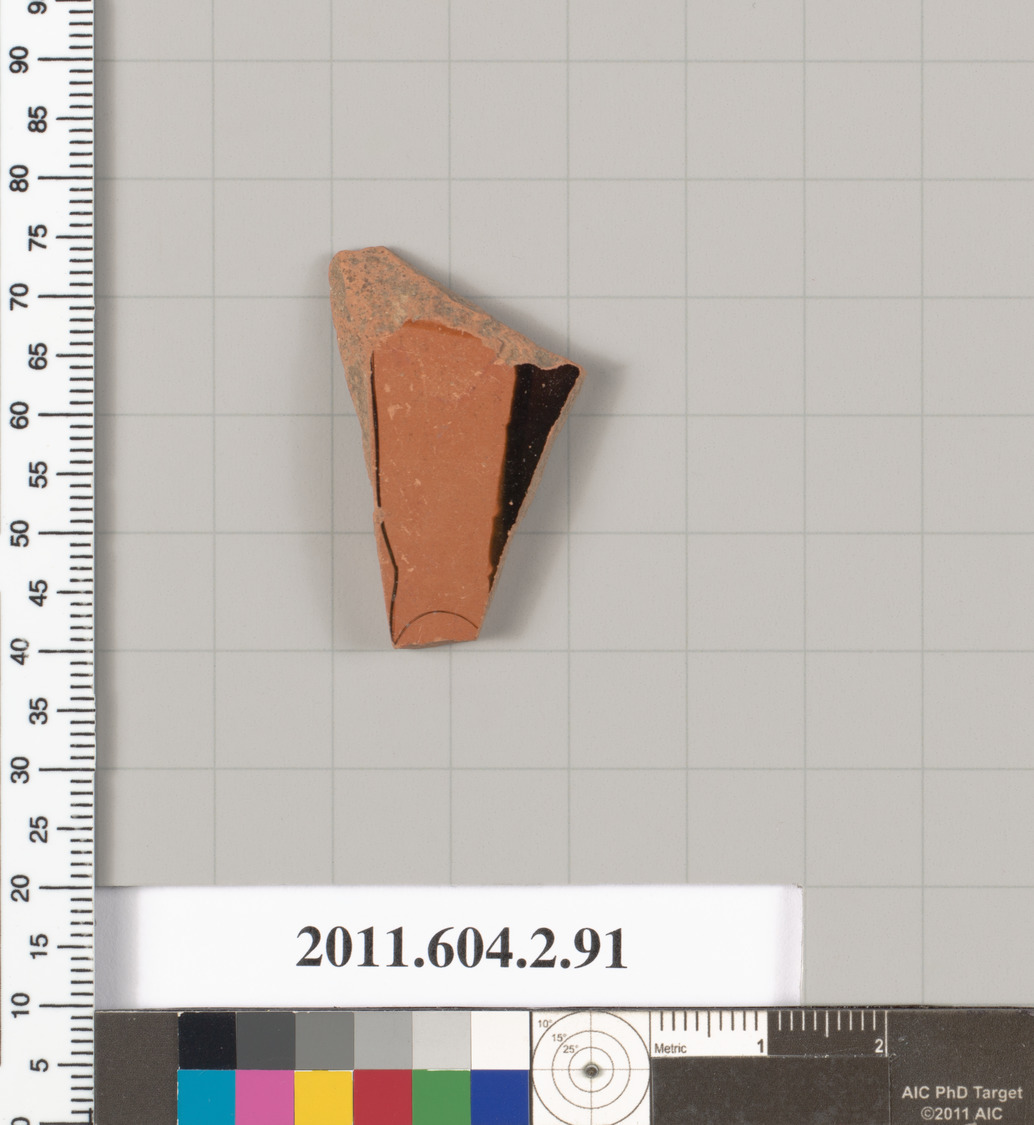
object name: pelike fragment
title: Terracotta fragment of a pelike (jar)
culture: greek, attic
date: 500-470 BCE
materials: terracotta